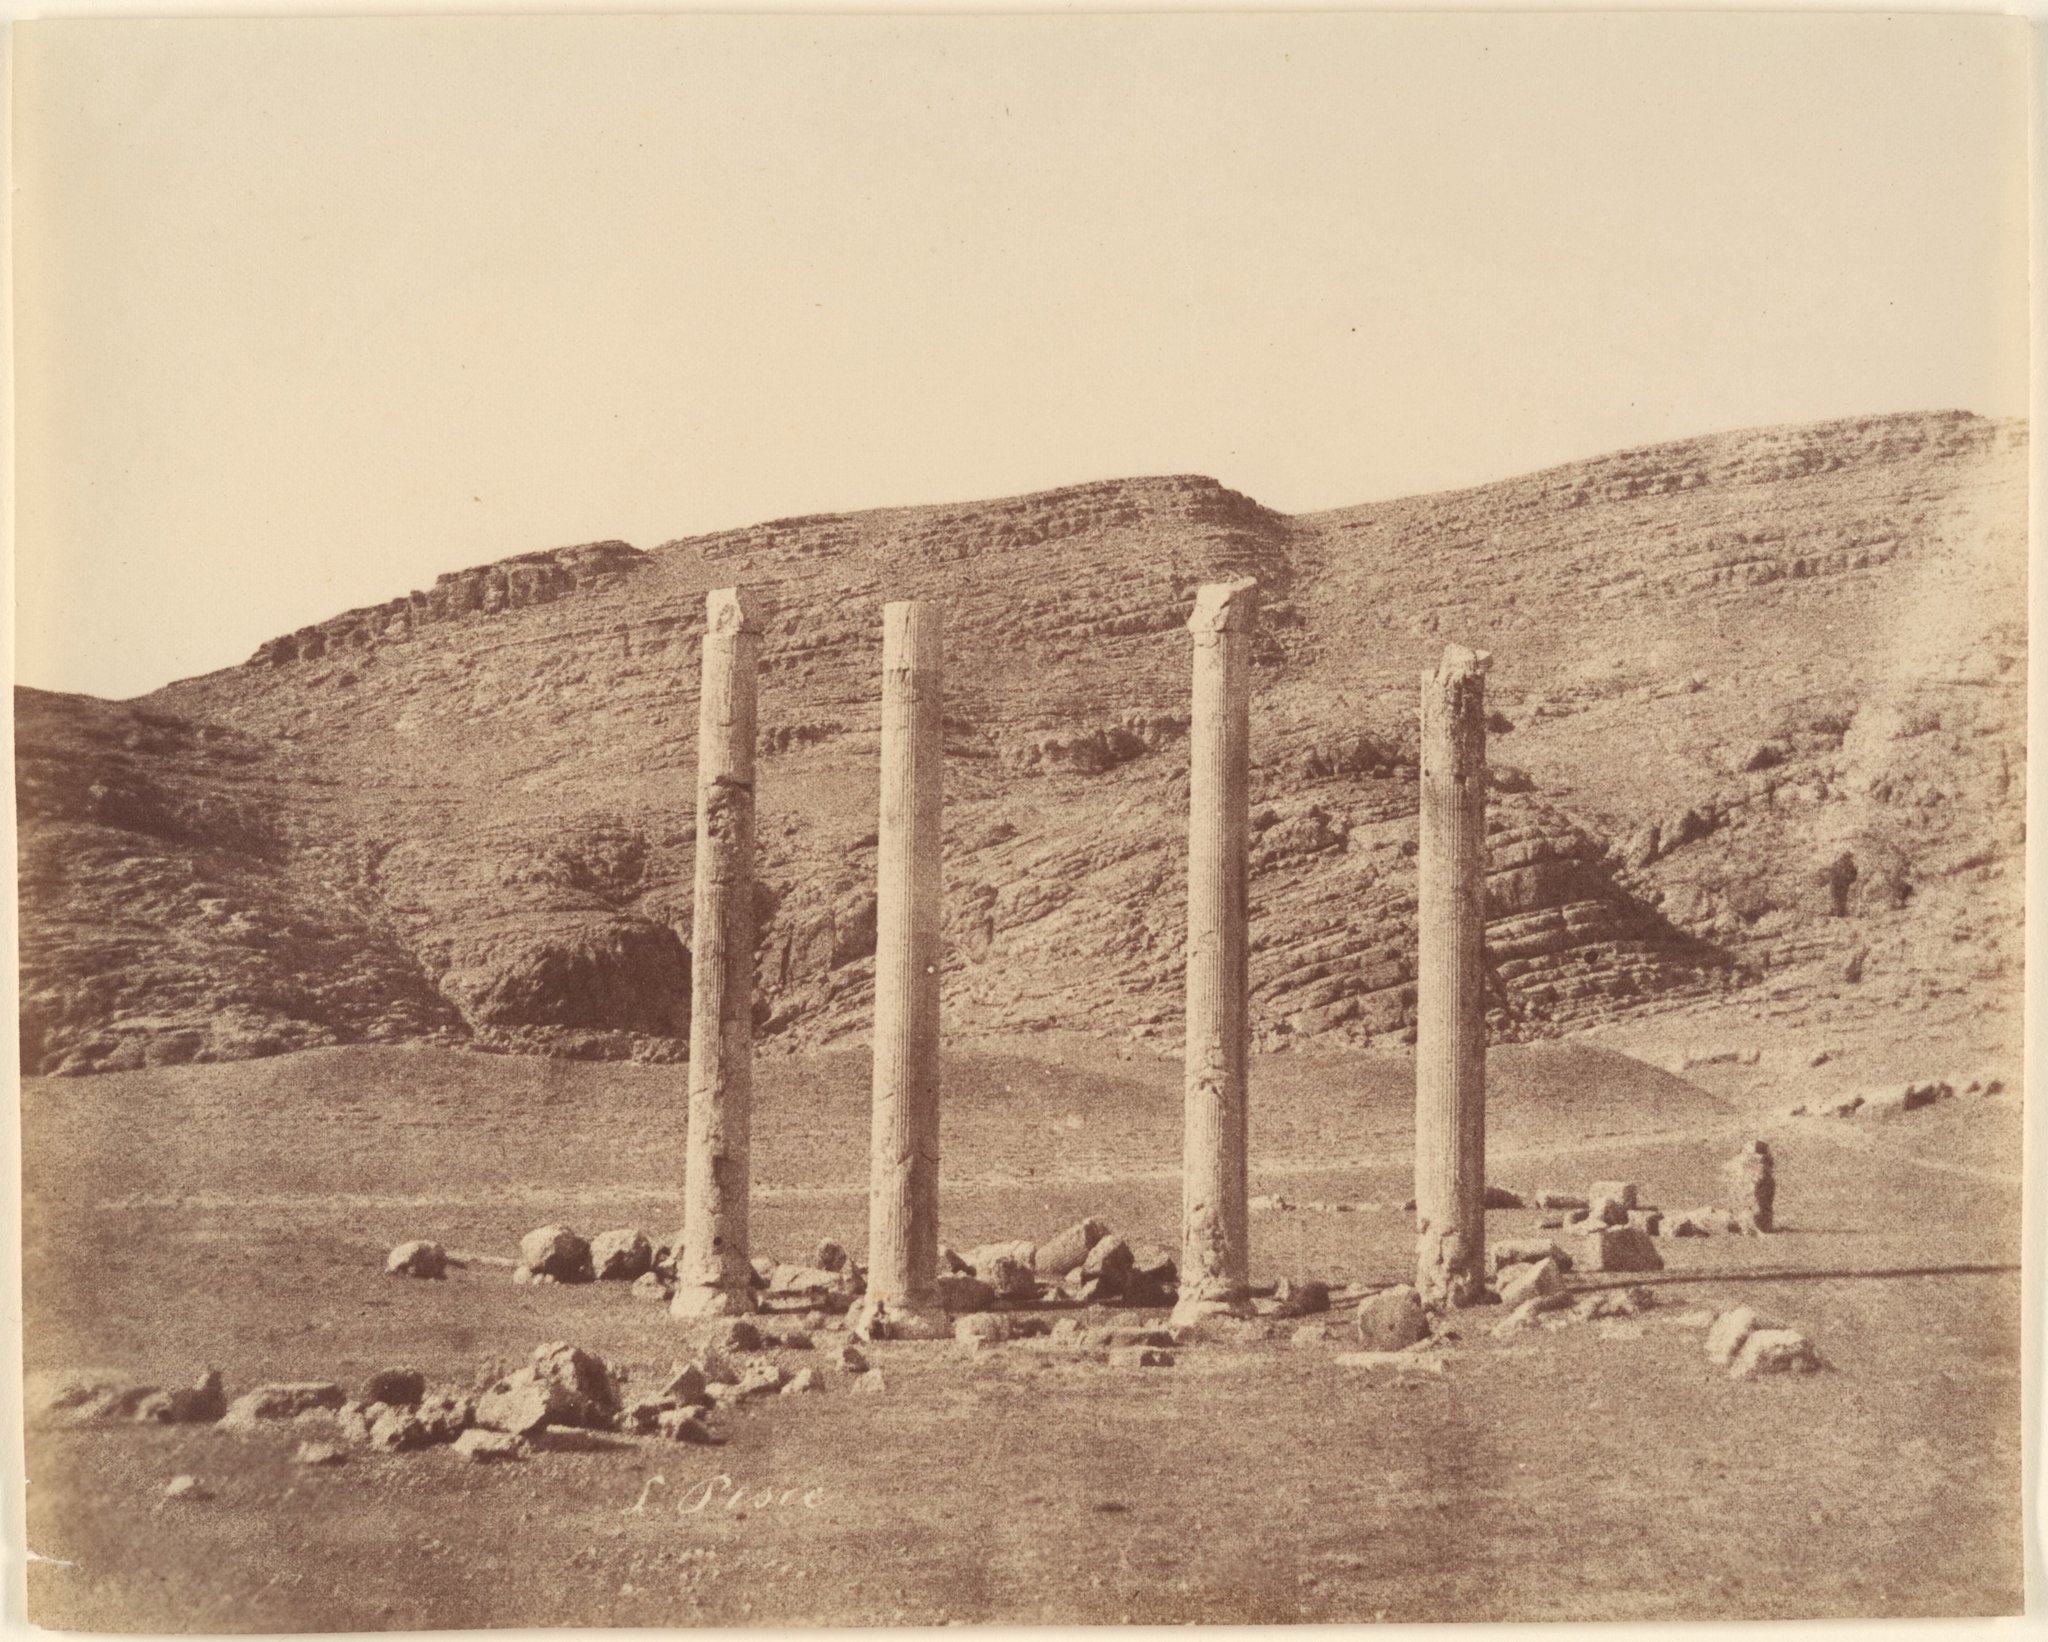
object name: photograph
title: (2) [Persepolis]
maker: luigi pesce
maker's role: artist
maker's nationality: italian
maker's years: 1818-1891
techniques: albumen silver print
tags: columns,ruins